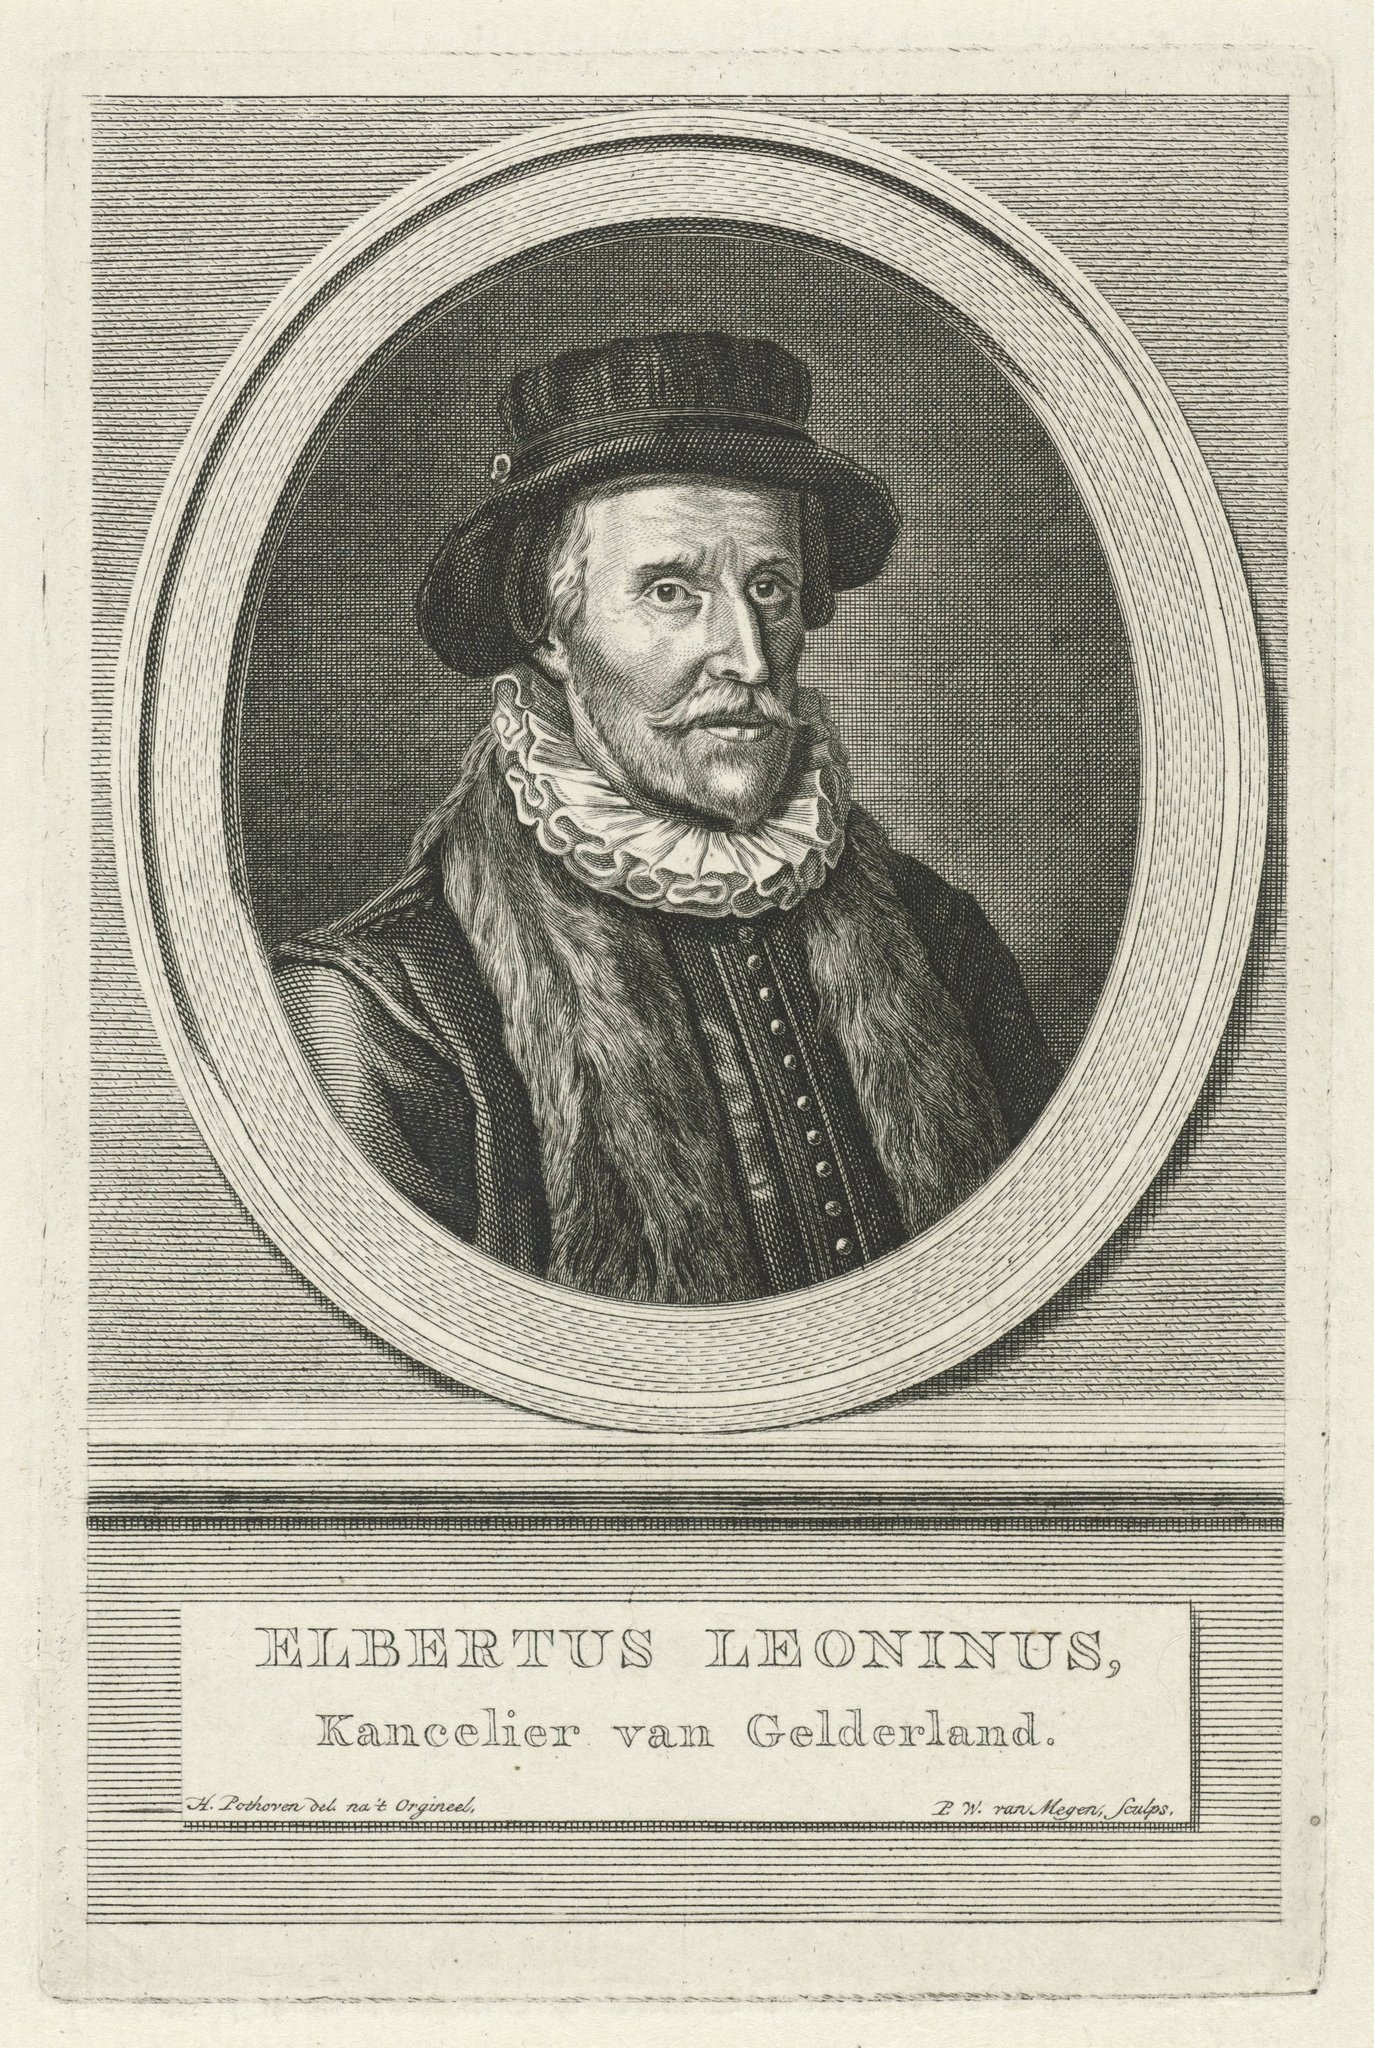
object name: print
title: Portret van Elbertus Leoninus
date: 1760-1785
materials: paper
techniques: engraving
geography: the hague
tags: politician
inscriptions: collector's mark: Lugt 2228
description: Portret van Elbertus Leoninus, kanselier van Gelderland.